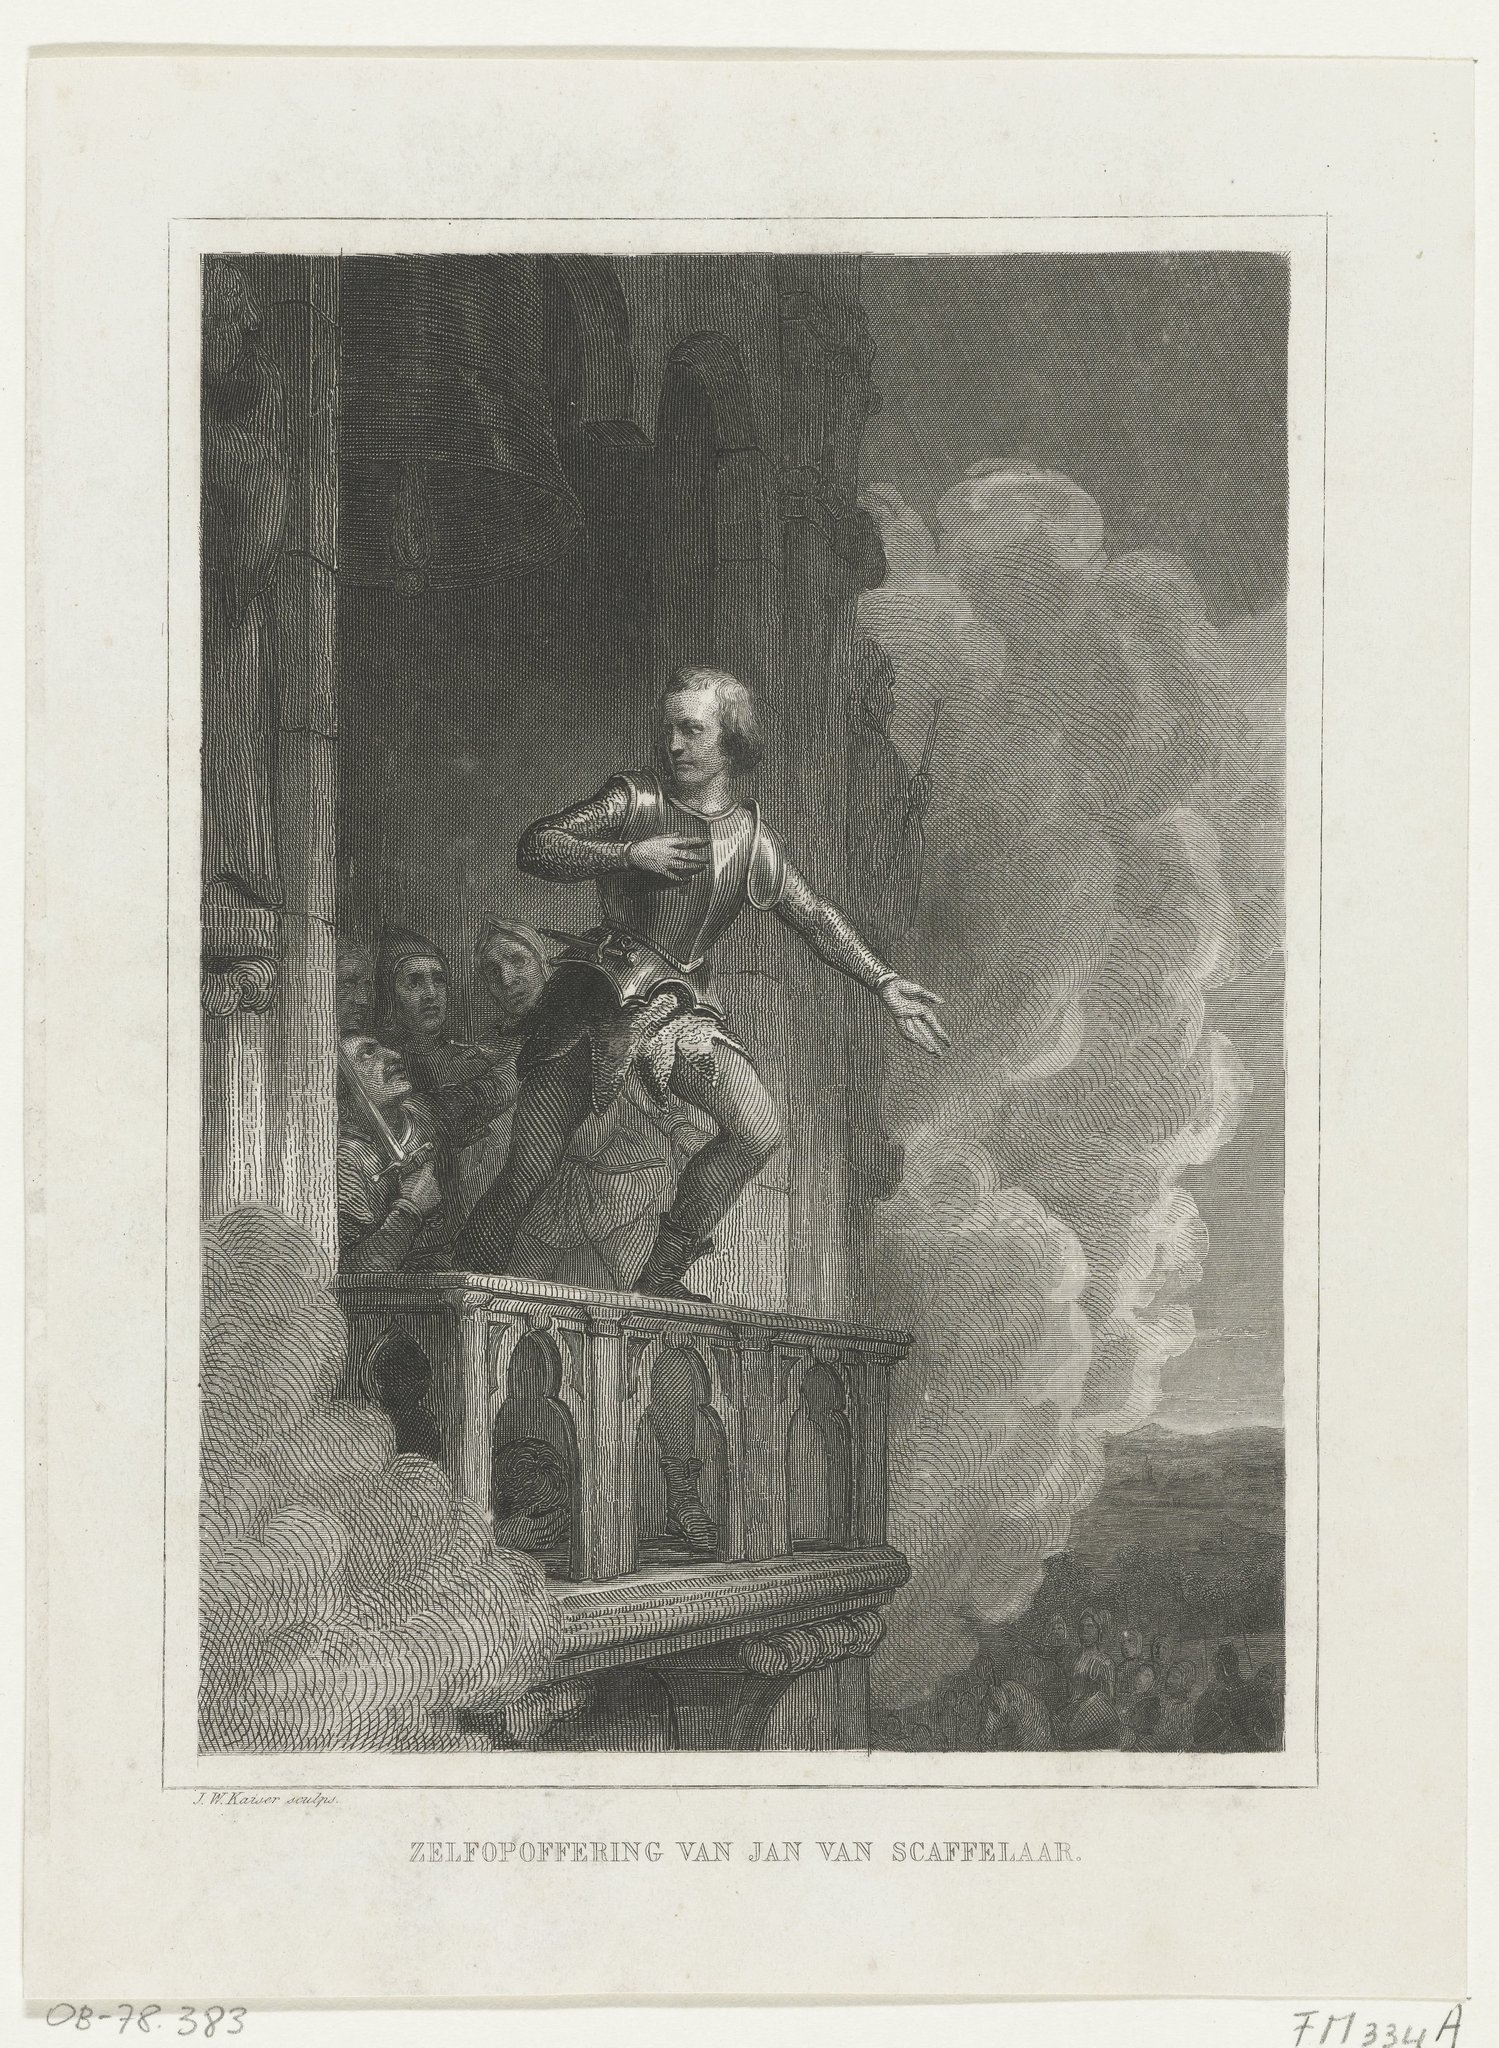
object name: print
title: Zelfopoffering van Jan van Scaffelaar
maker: johann wilhelm kaiser (i)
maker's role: draughtsman, print maker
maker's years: 1813-1900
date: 1844-1846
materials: paper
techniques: engraving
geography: netherlands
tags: self-sacrifice, death in the service of a higher purpose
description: Illustratie voor: J.P. Arend, Algemeene geschiedenis des vaderlands, Amsterdam, 5 delen, 1840-1882, dl. 2.3, p. 126. Niet in Frederik Muller; door het RPK toegevoegd nummer.